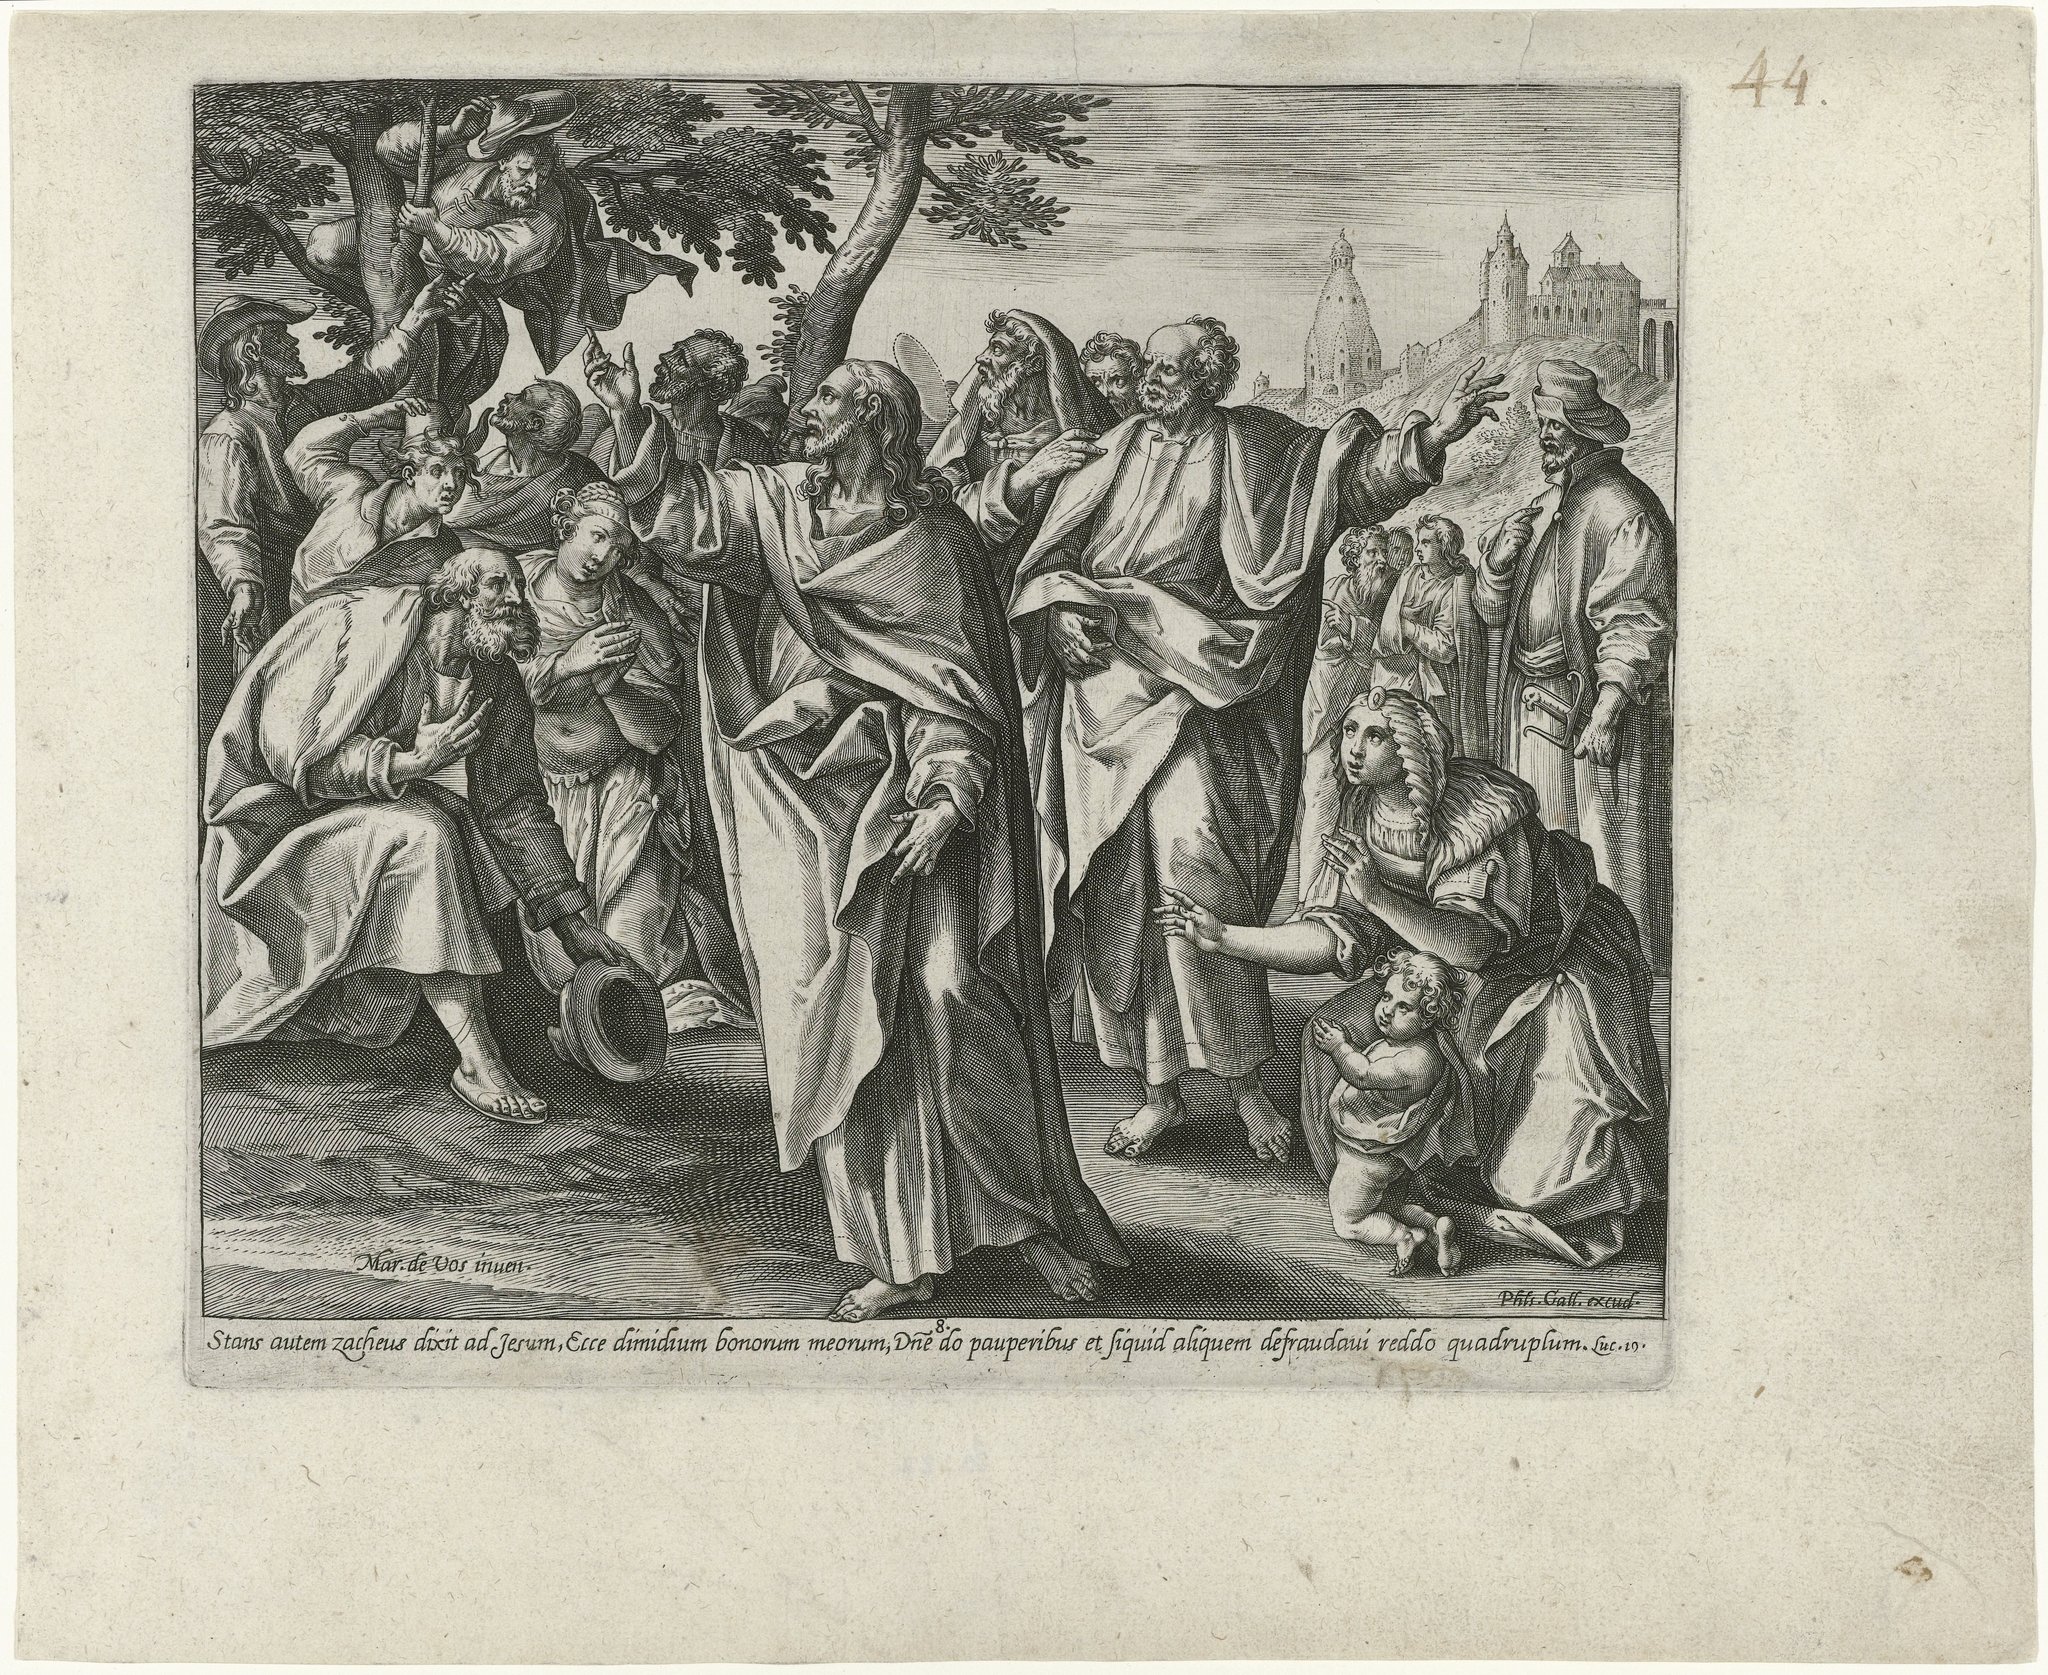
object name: print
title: Roeping van Zacheus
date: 1547-1612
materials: paper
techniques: engraving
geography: antwerp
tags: calling of zacchaeus, who is sitting in a fig-tree (christ passing through jericho)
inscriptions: collector's mark: Lugt 2760, collector's mark: Lugt 2228, number: ‘44’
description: De tollenaar Zacheus is in een boom gekropen om Christus te zien bij zijn intocht in Jericho. Christus roept Zacheus bij zich en vergeeft zijn zonden nadat hij berouw heeft getoond. De prent heeft een Latijns onderschrift en is deel van een serie over boetedoening en berouw in het Oude en Nieuwe Testament.